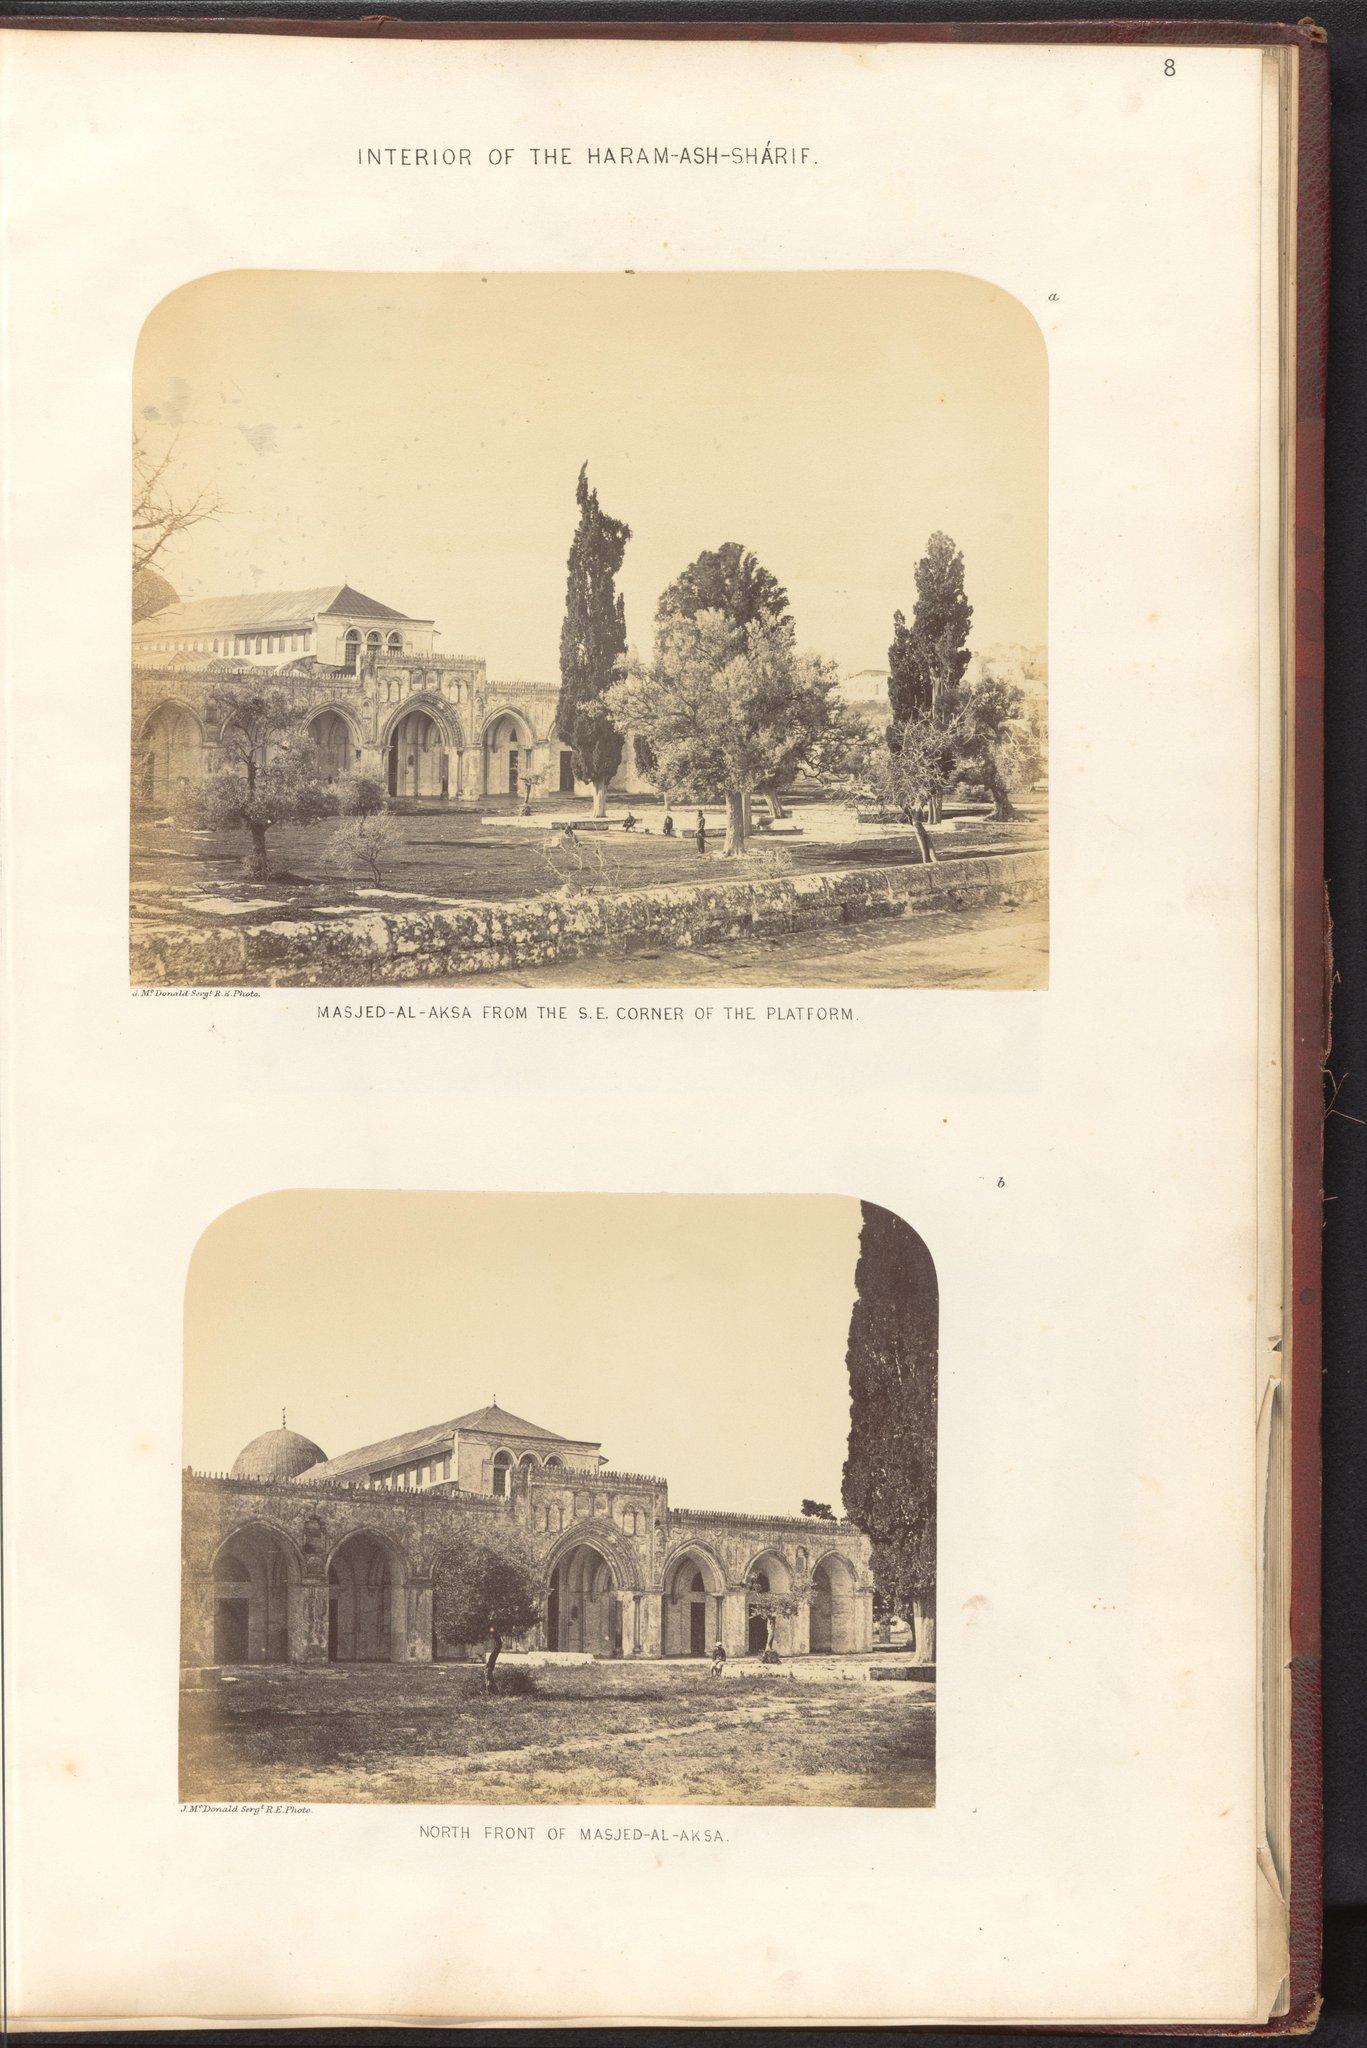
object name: page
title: North Front of Masjed-Al-Aksa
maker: james mcdonald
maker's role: fotograaf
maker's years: 1822-1885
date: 1860-1865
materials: paper, photographic support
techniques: albumen print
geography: tempelberg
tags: temple, shrine ~ islam, mohammedanism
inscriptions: inscription: ‘a’, inscription: ‘b’